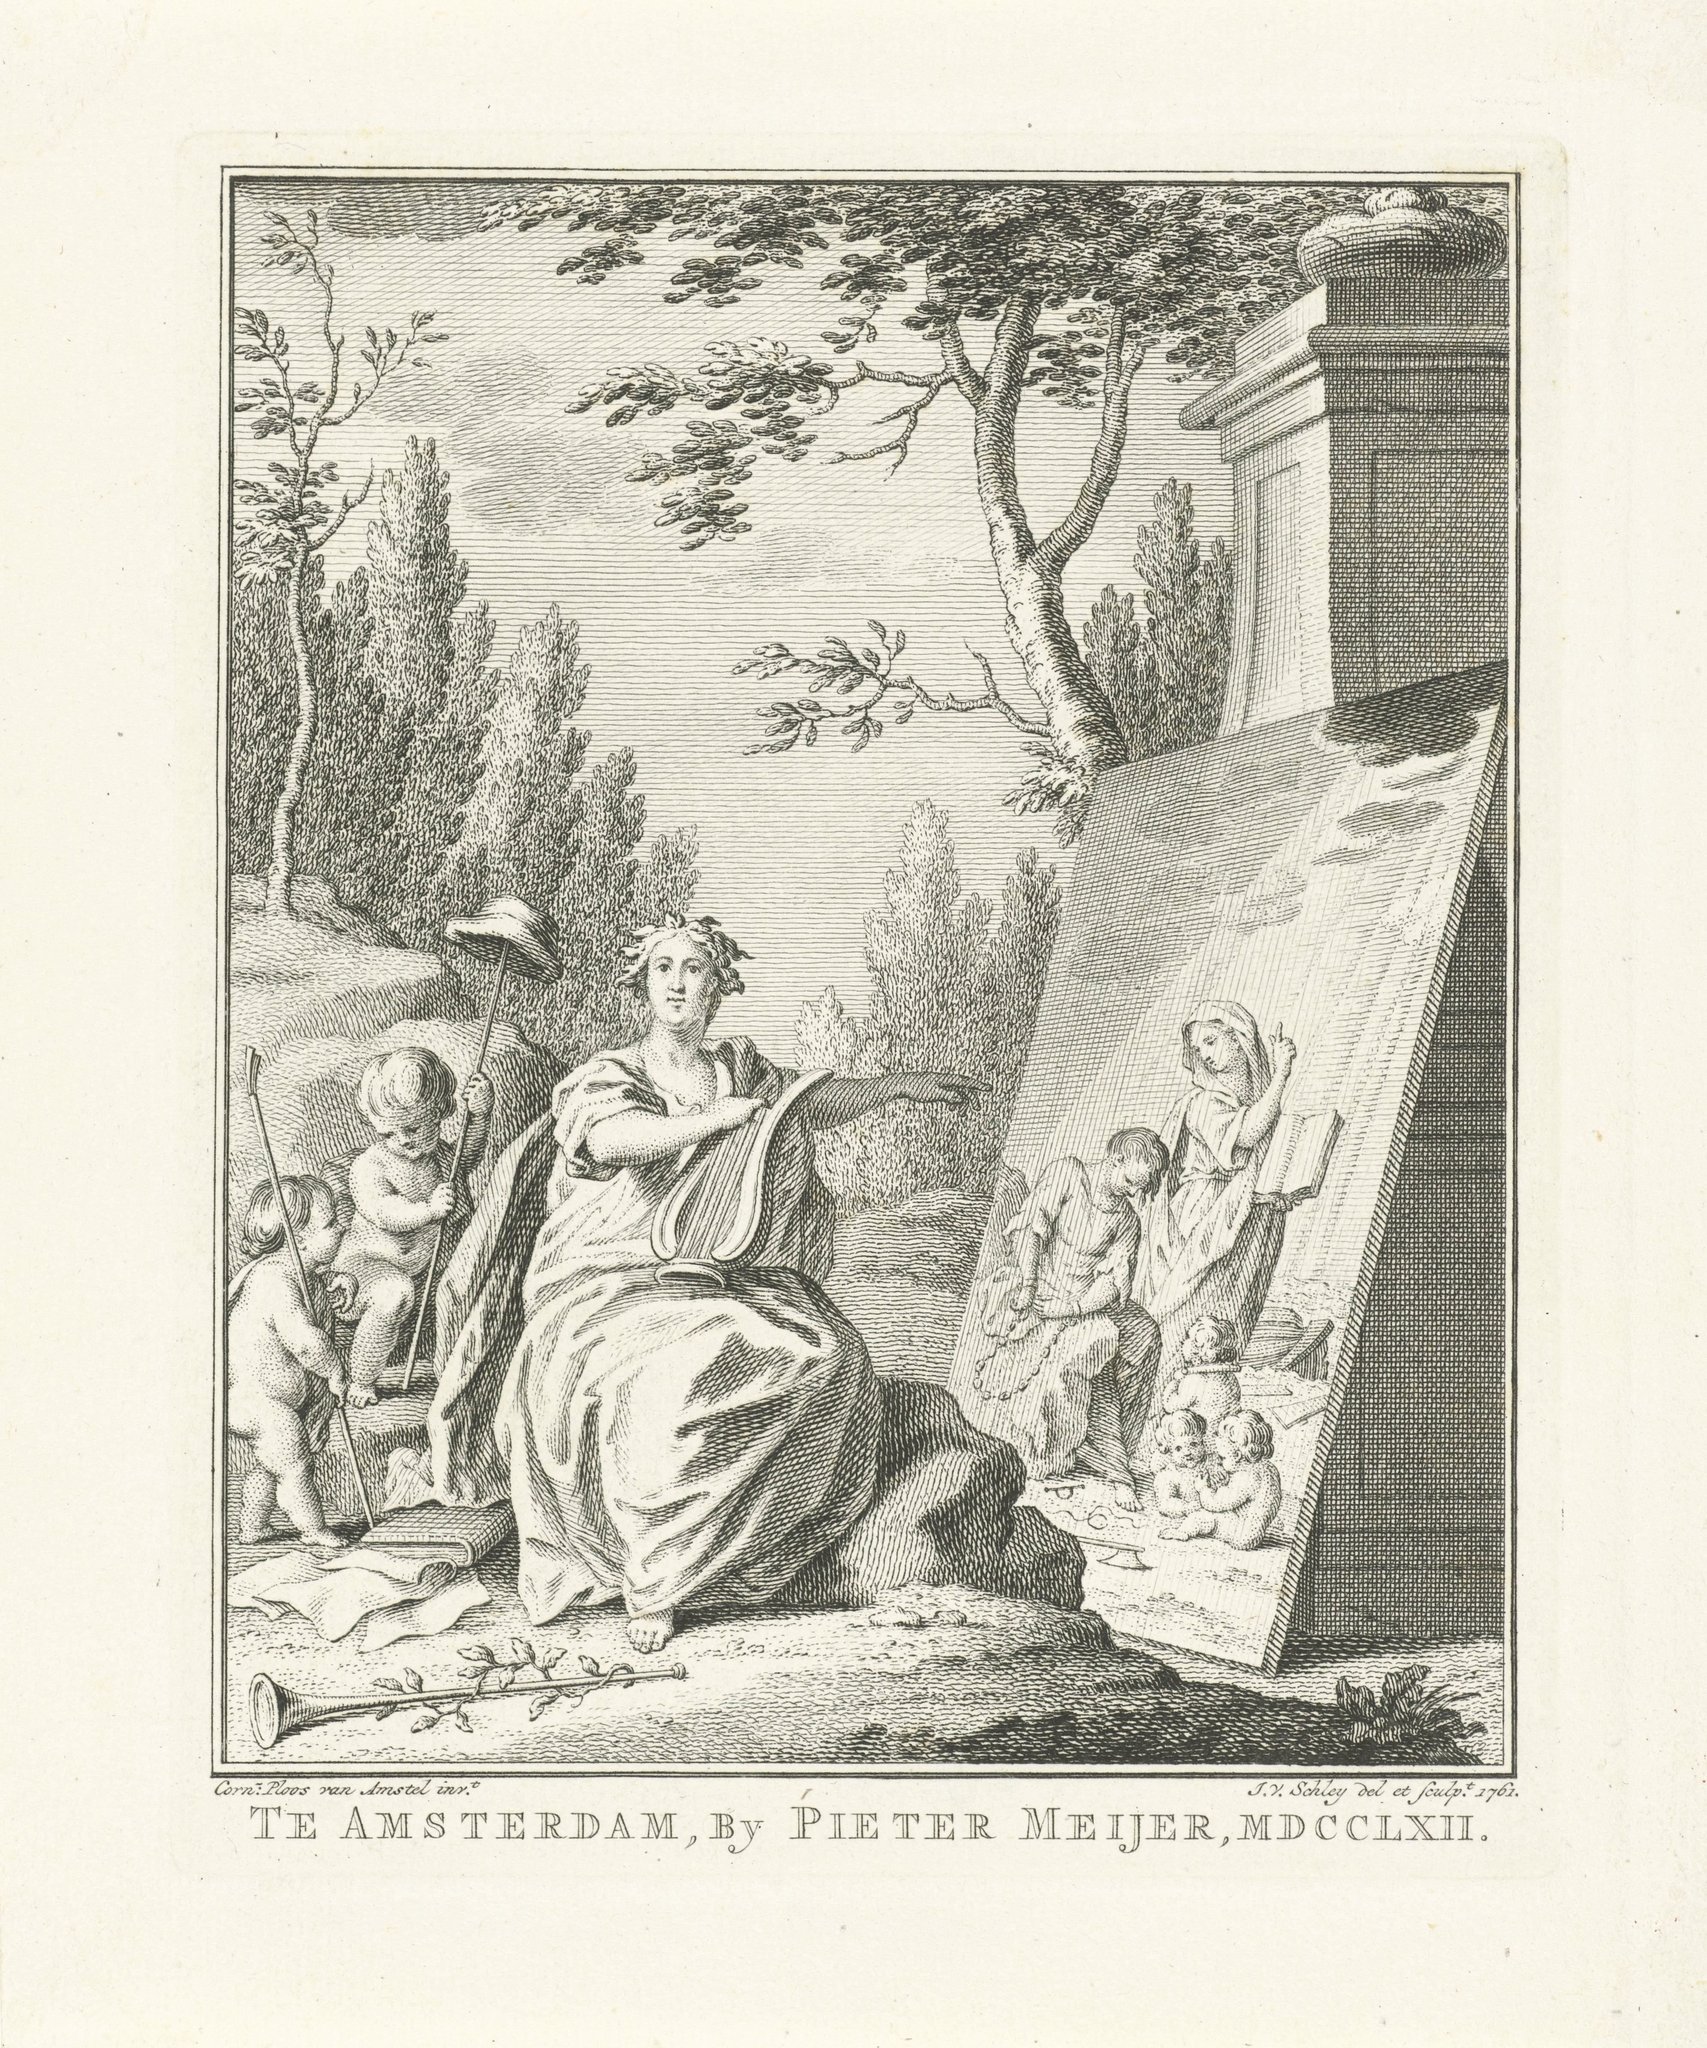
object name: print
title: Titelprent voor L.W. van Merken, Lof der Tegenspoed, 1762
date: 1762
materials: paper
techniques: engraving, etching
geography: amsterdam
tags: fides (faith) as roman personification, freedom, liberty; 'libertà' (ripa)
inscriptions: collector's mark: Lugt 240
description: Titelprent voor L.W. van Merken, Lof der Tegenspoed, 1762, met de personificatie van Vrijheid die wijst op een schilderij waarop de personificatie van Geloof staat.